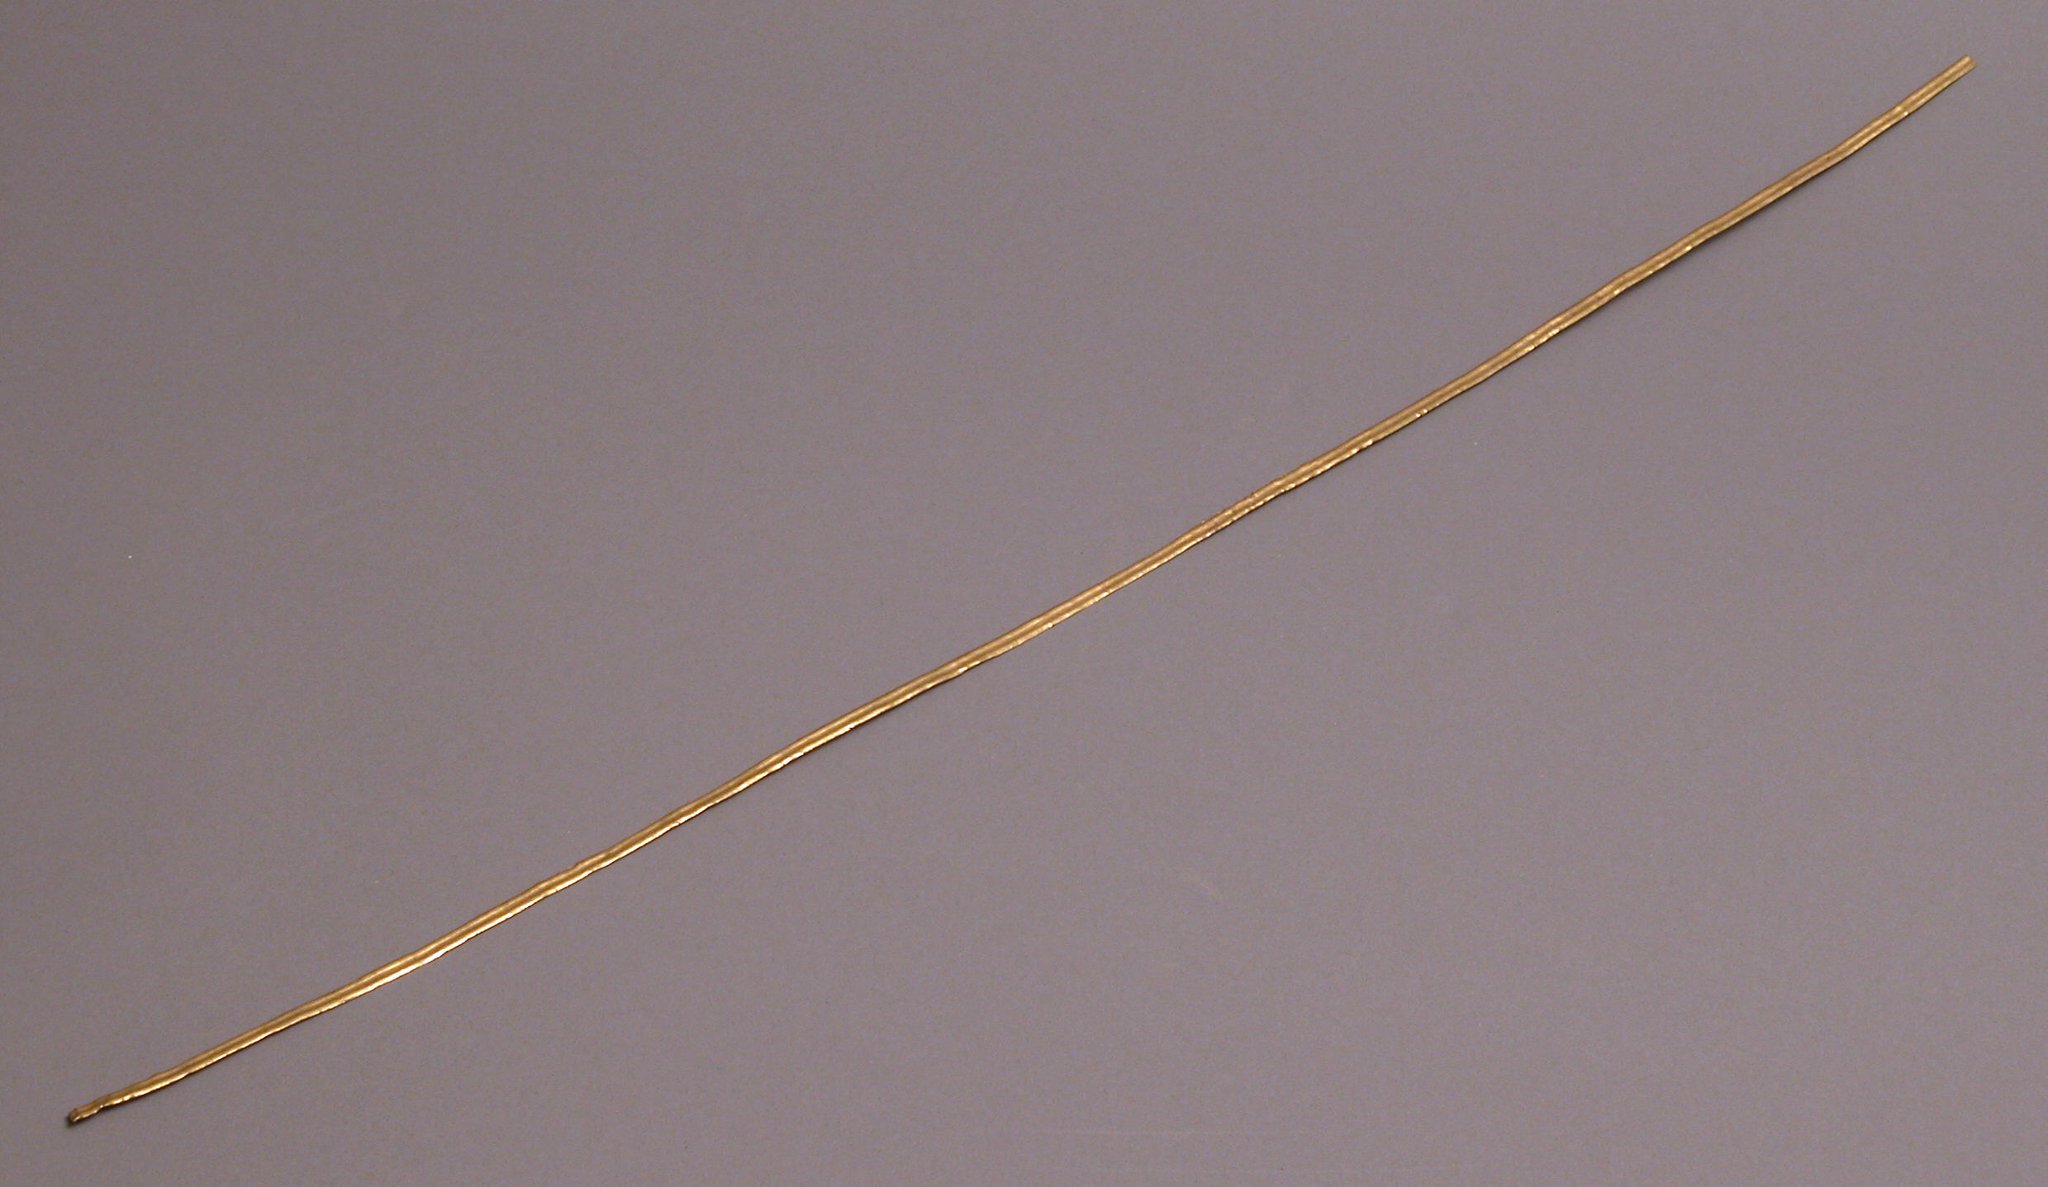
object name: lamella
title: Gold Strip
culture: avar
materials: gold